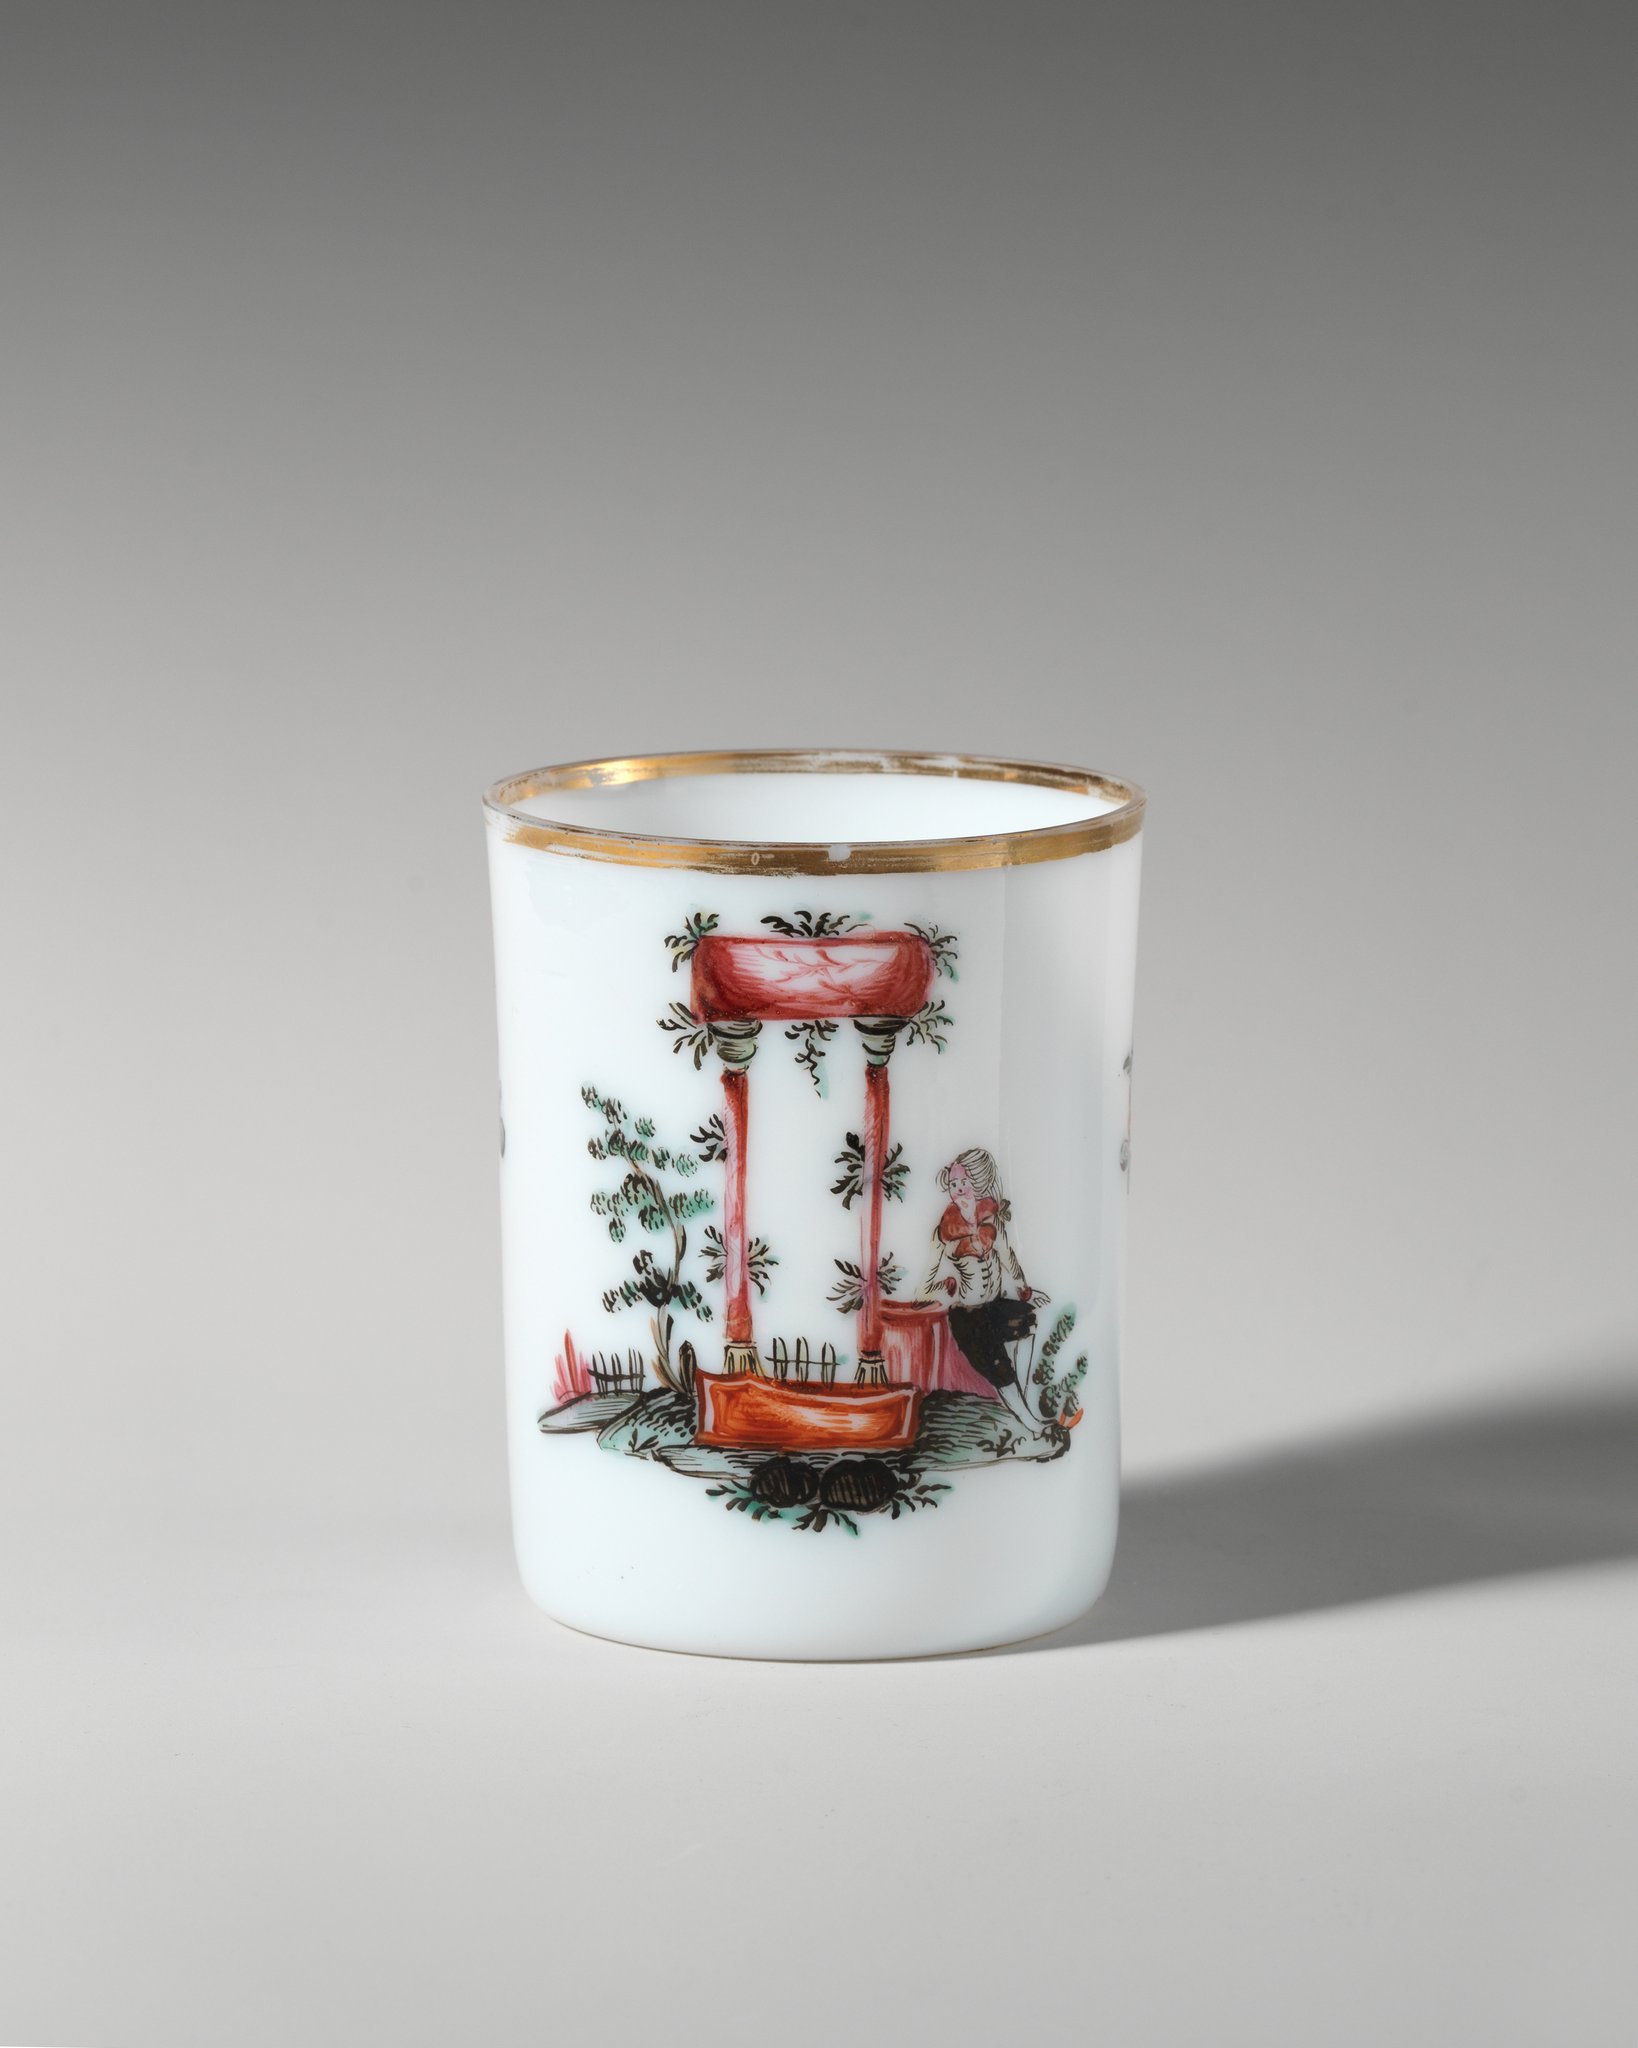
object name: mug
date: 1767-1800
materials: glass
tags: women,trees